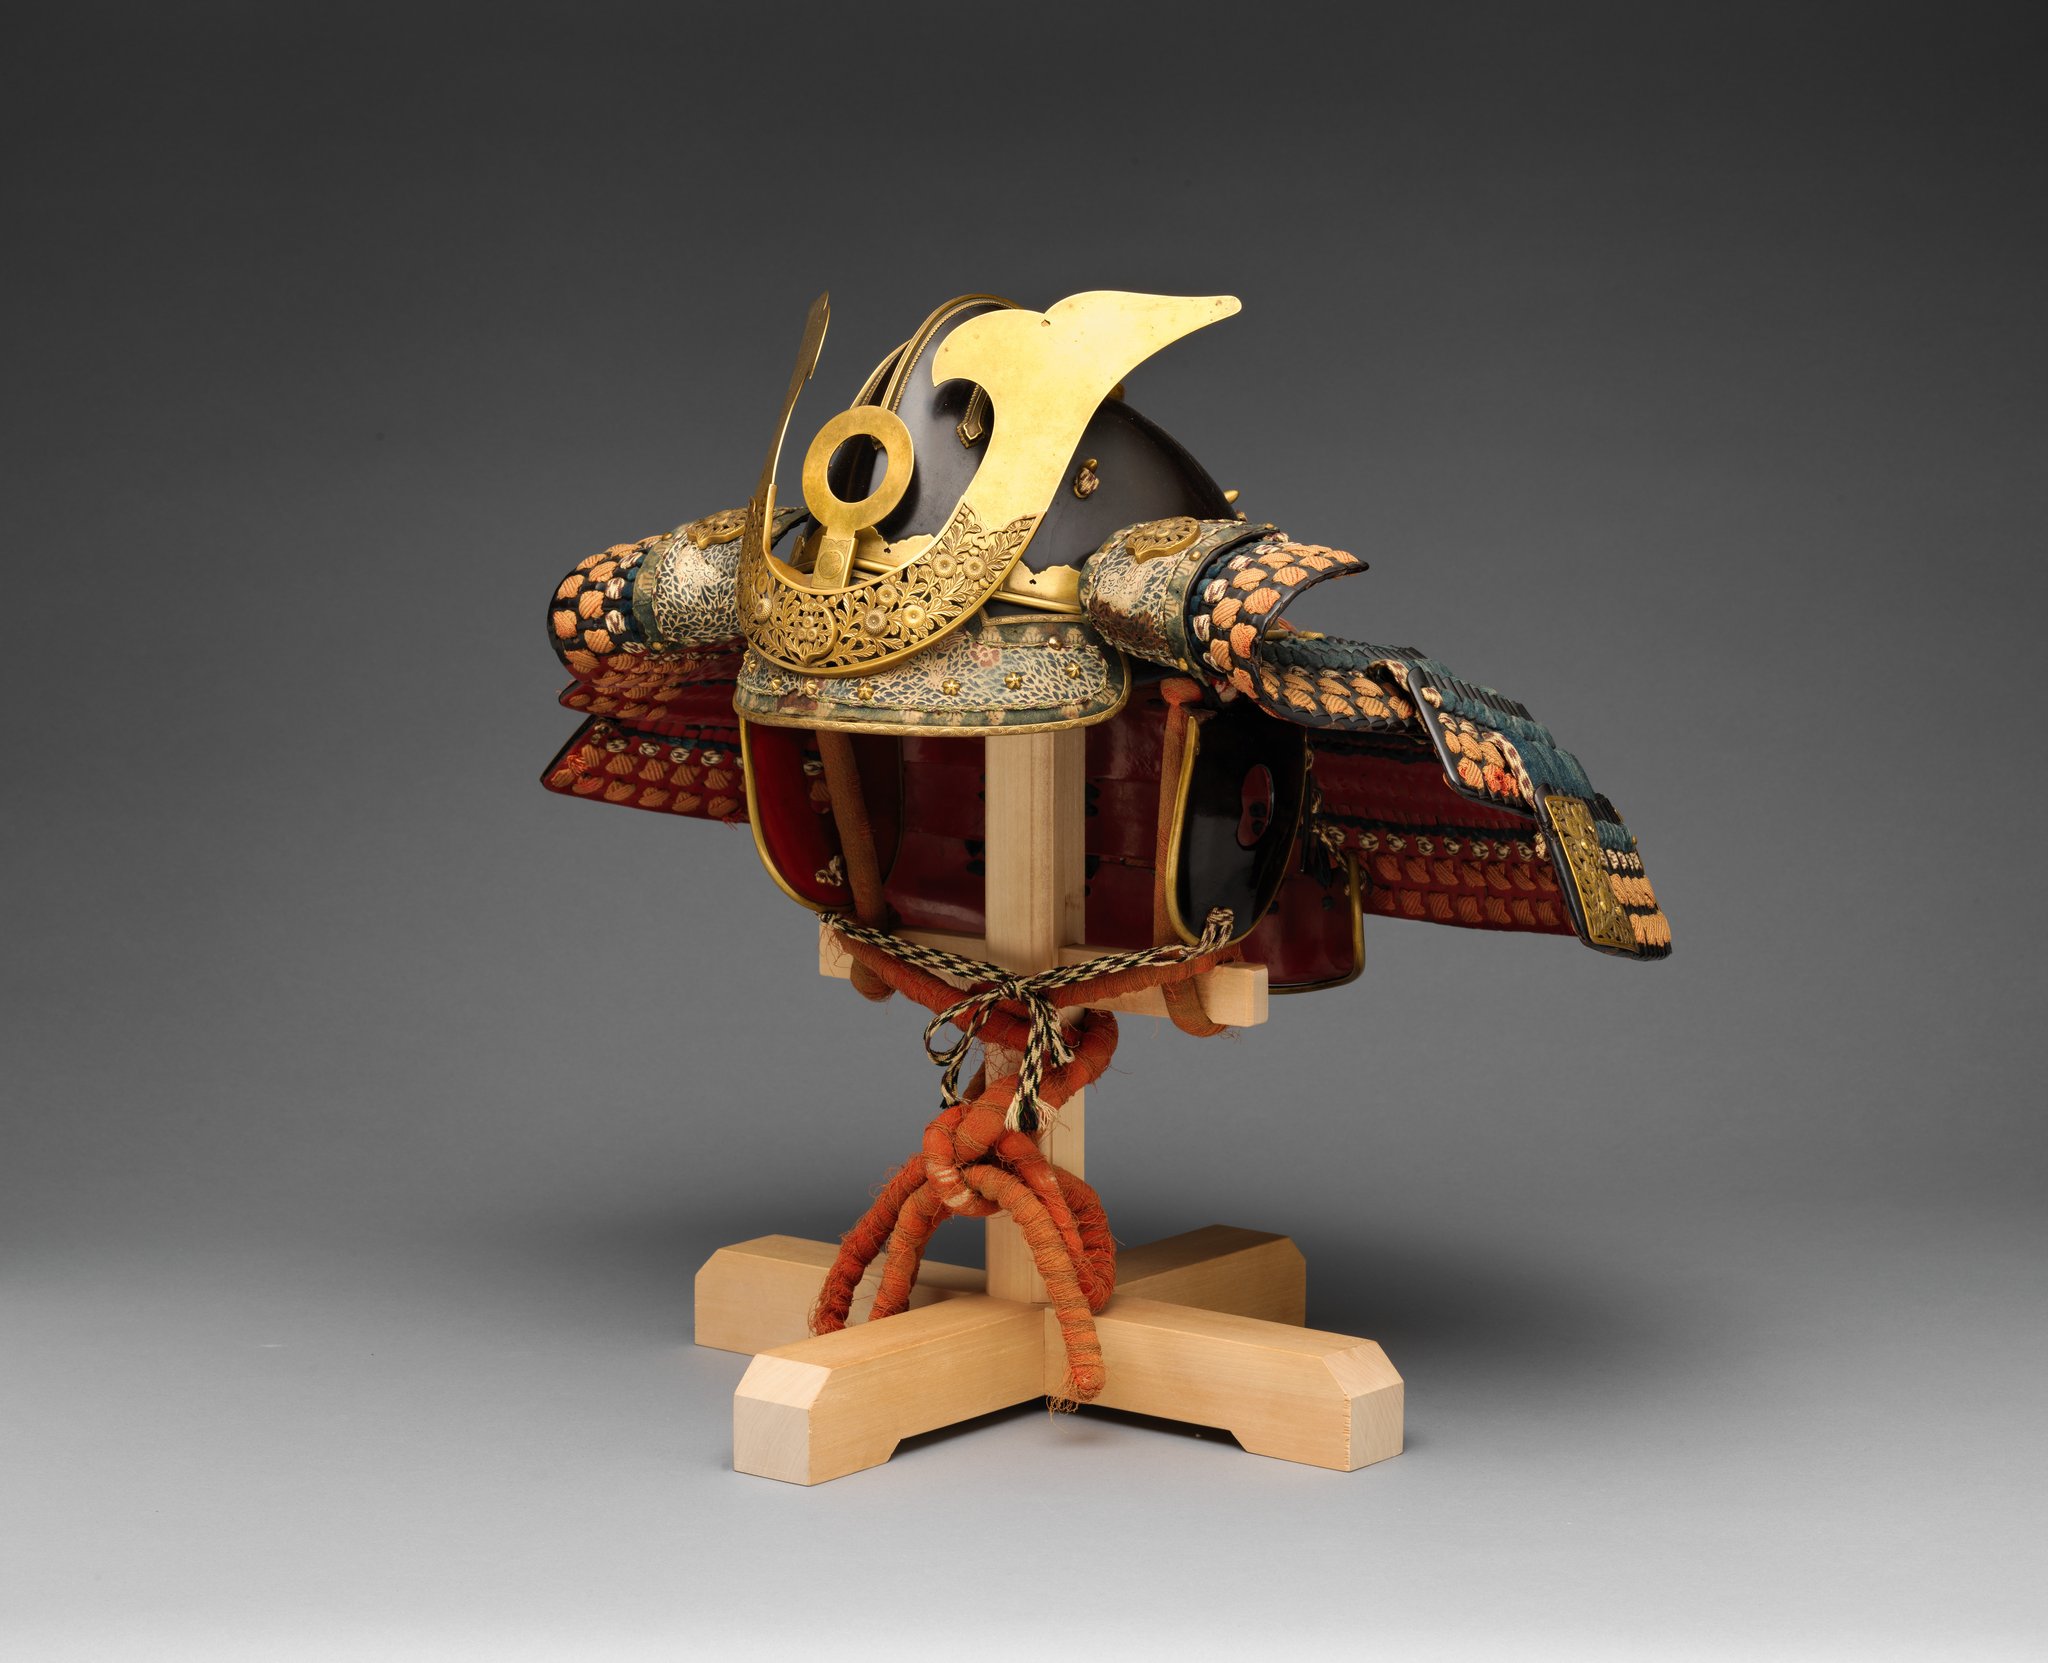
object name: helmet with case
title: Helmet in the Zenshōzan Style with Case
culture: japanese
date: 1700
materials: copper alloy, gold, lacquer, leather, steel, textile, wood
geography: japan